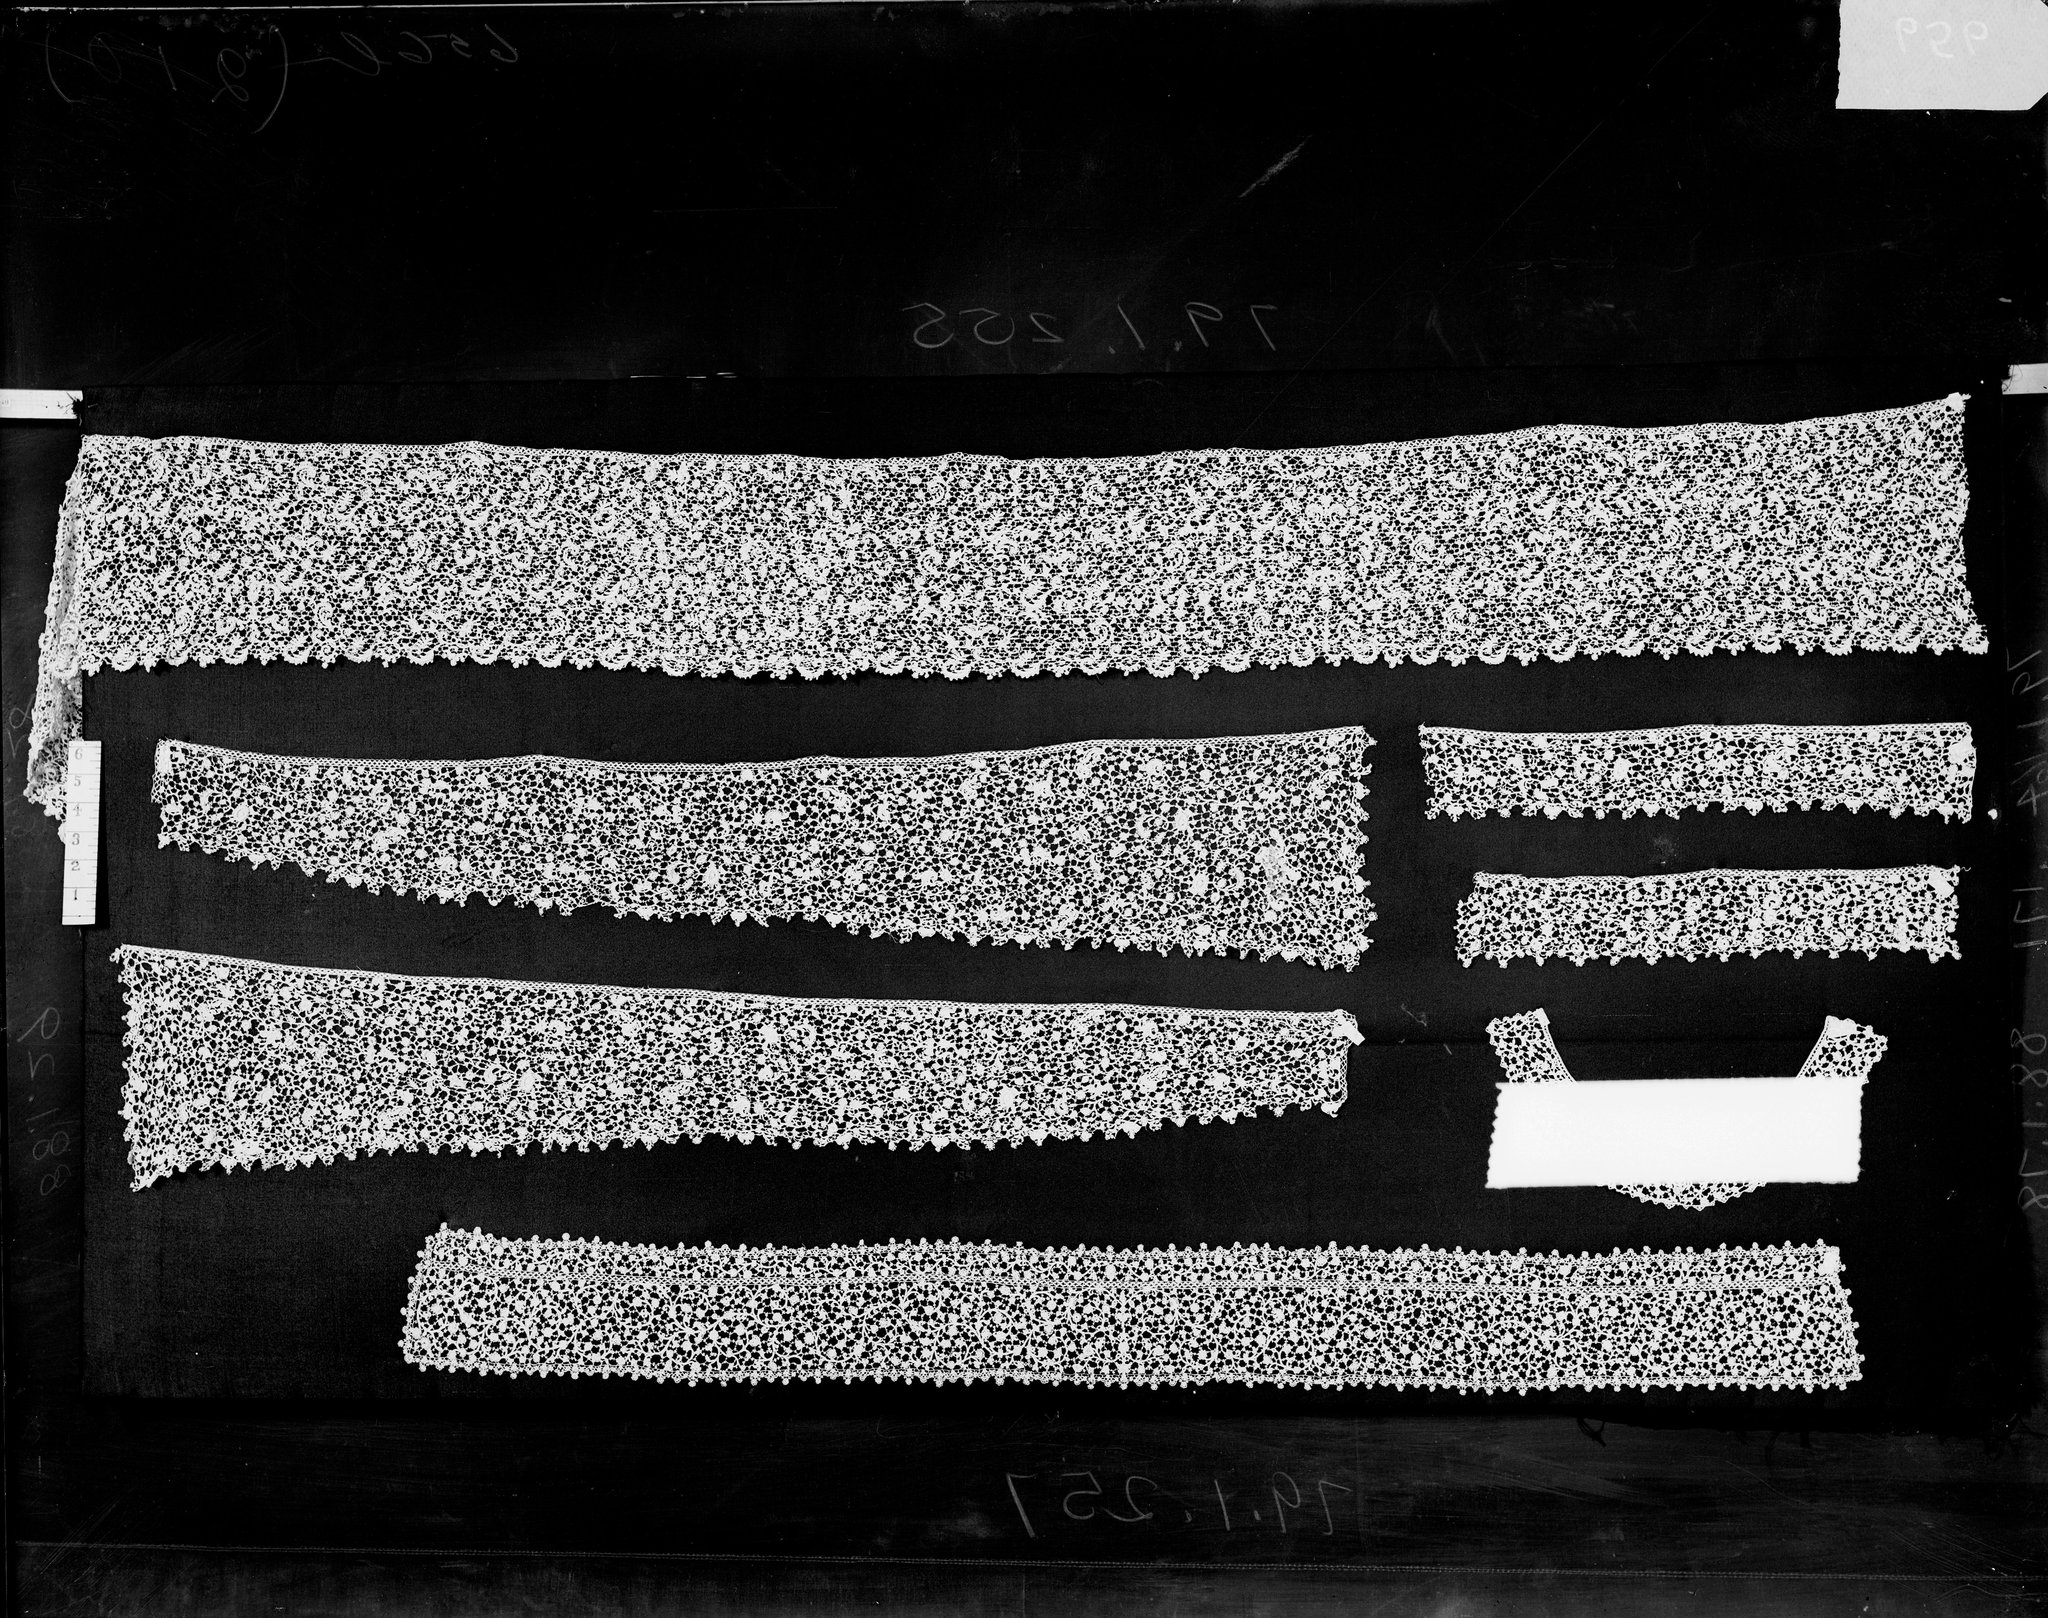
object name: strip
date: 1701-1733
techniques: lace